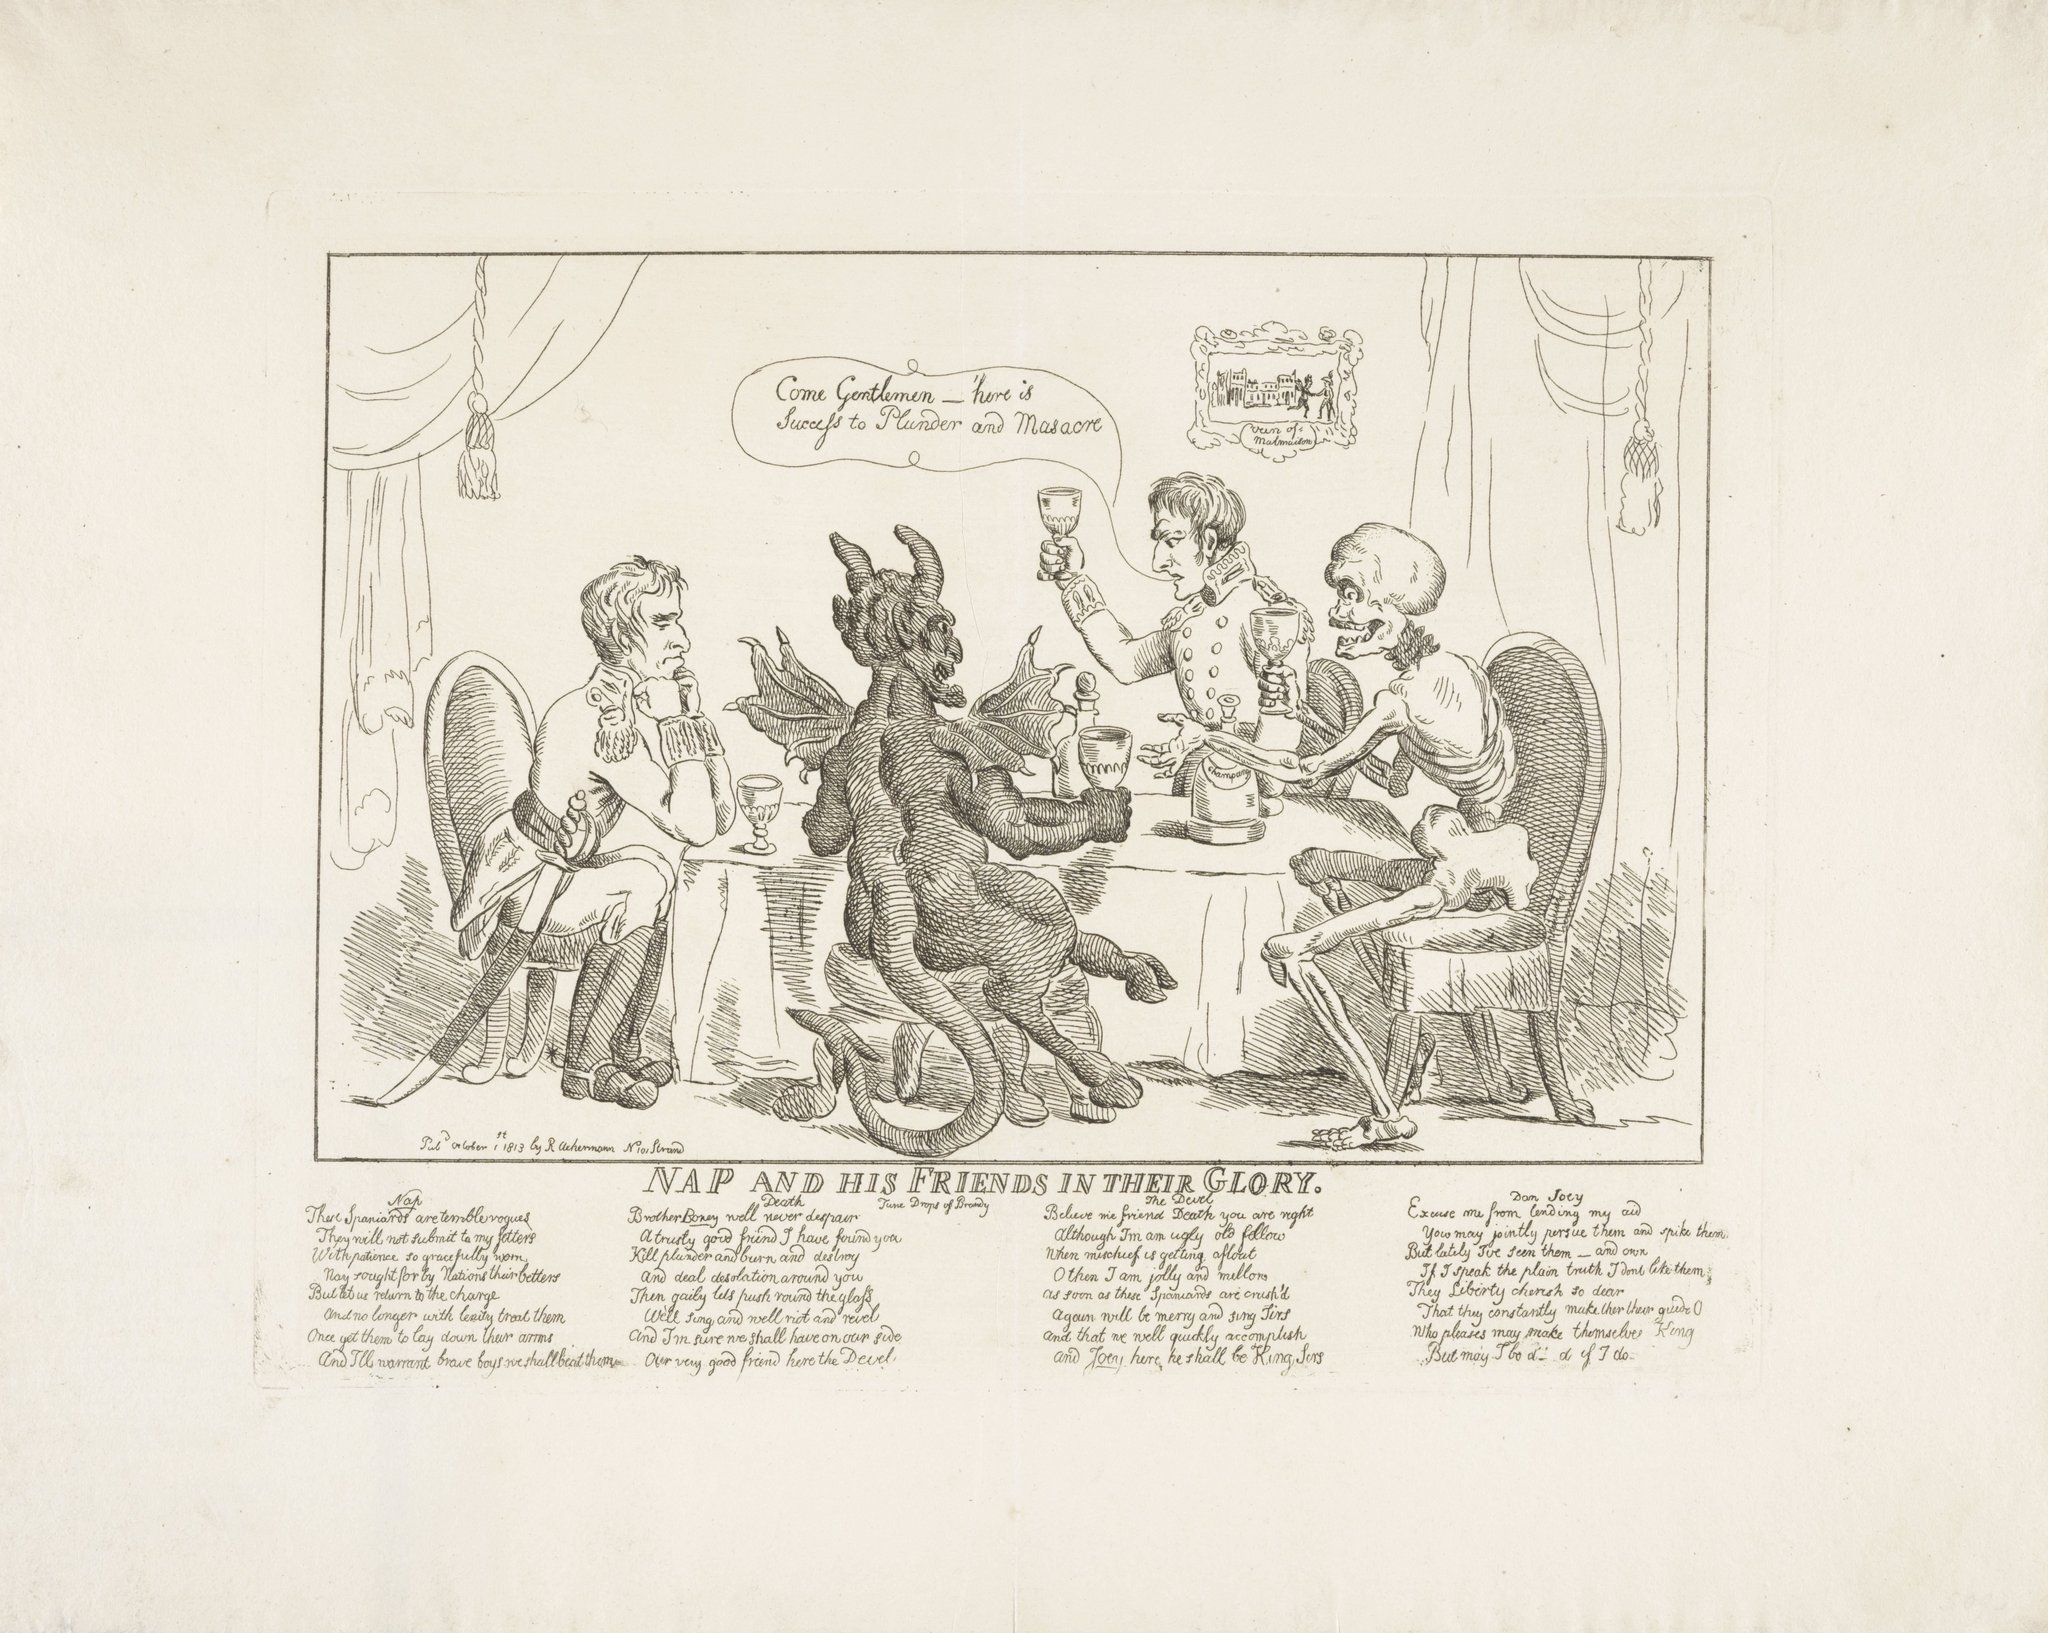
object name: print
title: Napoleon en zijn vrienden in hun glorie, 1813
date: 1808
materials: paper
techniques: etching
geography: london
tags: napoleon i (emperor of the french), banquet of elegant company (+ toast at meal, banquet), death as skeleton, devil(s) and demons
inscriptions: collector's mark: Lugt 2228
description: Spotprent op Napoleon, 1813. Aan een tafel zitten Napoleon, zijn broer Jozef, de Dood en de Duivel. Napoleon wil een toast uitbrengen en met de anderen drinken op het succes van plundering en moord. Jozef Bonaparte zit er enigszins beteuterd bij met het hoofd in de handen. In het onderschrift vier verzen namens de vier hoofdpersonen in de voorstelling. Bij de prent behoort een afzonderlijke verklaring.